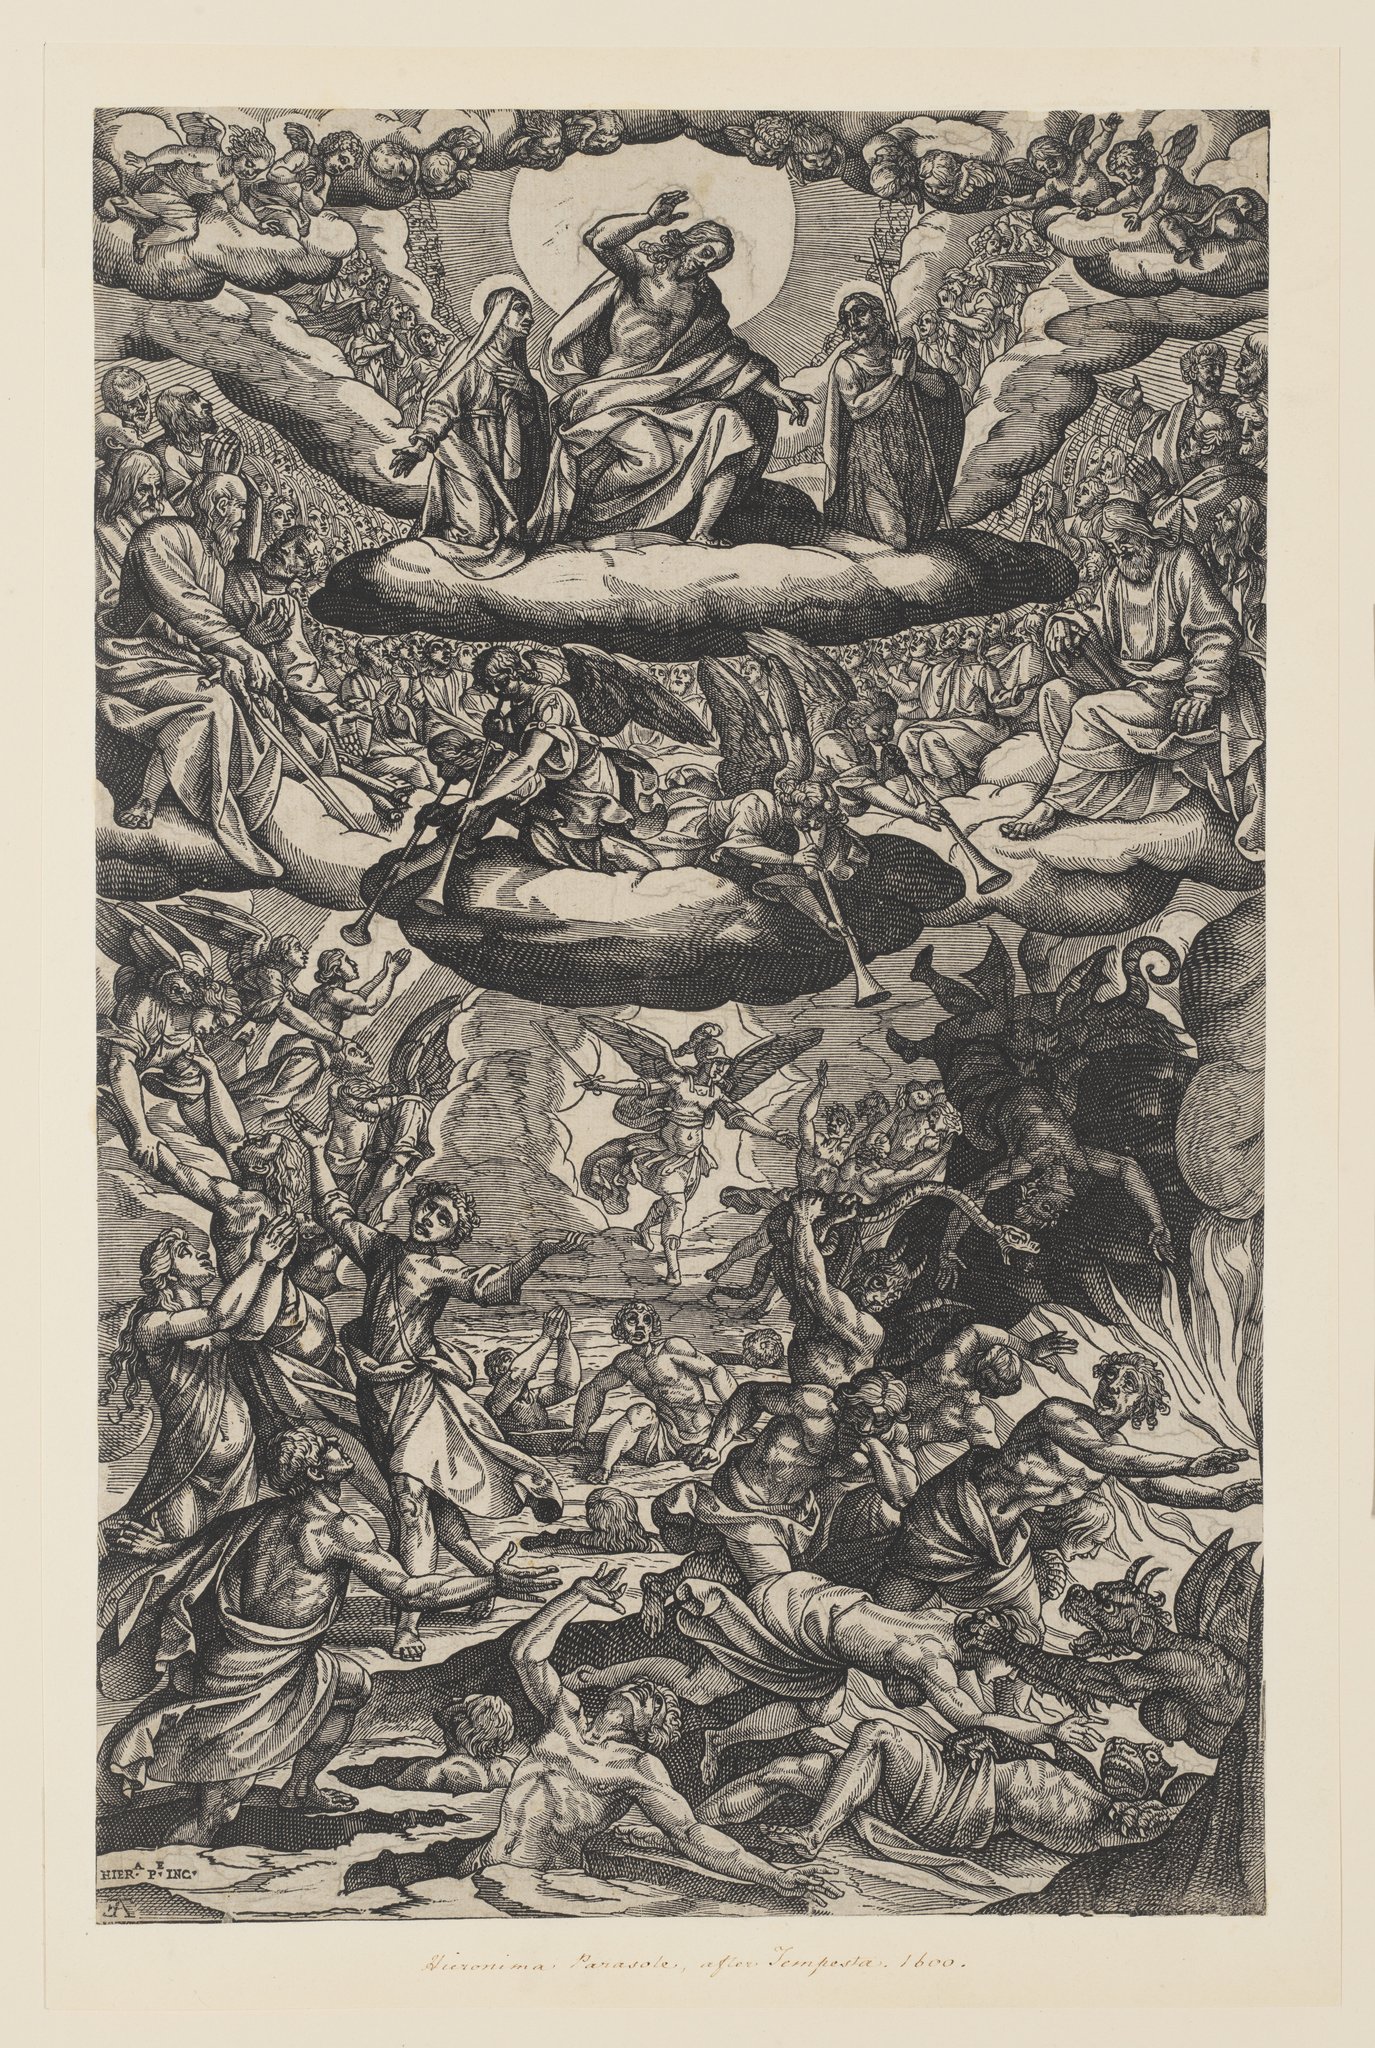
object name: print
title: The Last Judgment with Christ on a Cloud above and with the damned below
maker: geronima parasole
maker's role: artist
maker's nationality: italian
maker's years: 1600-1622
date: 1600-1622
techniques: woodcut